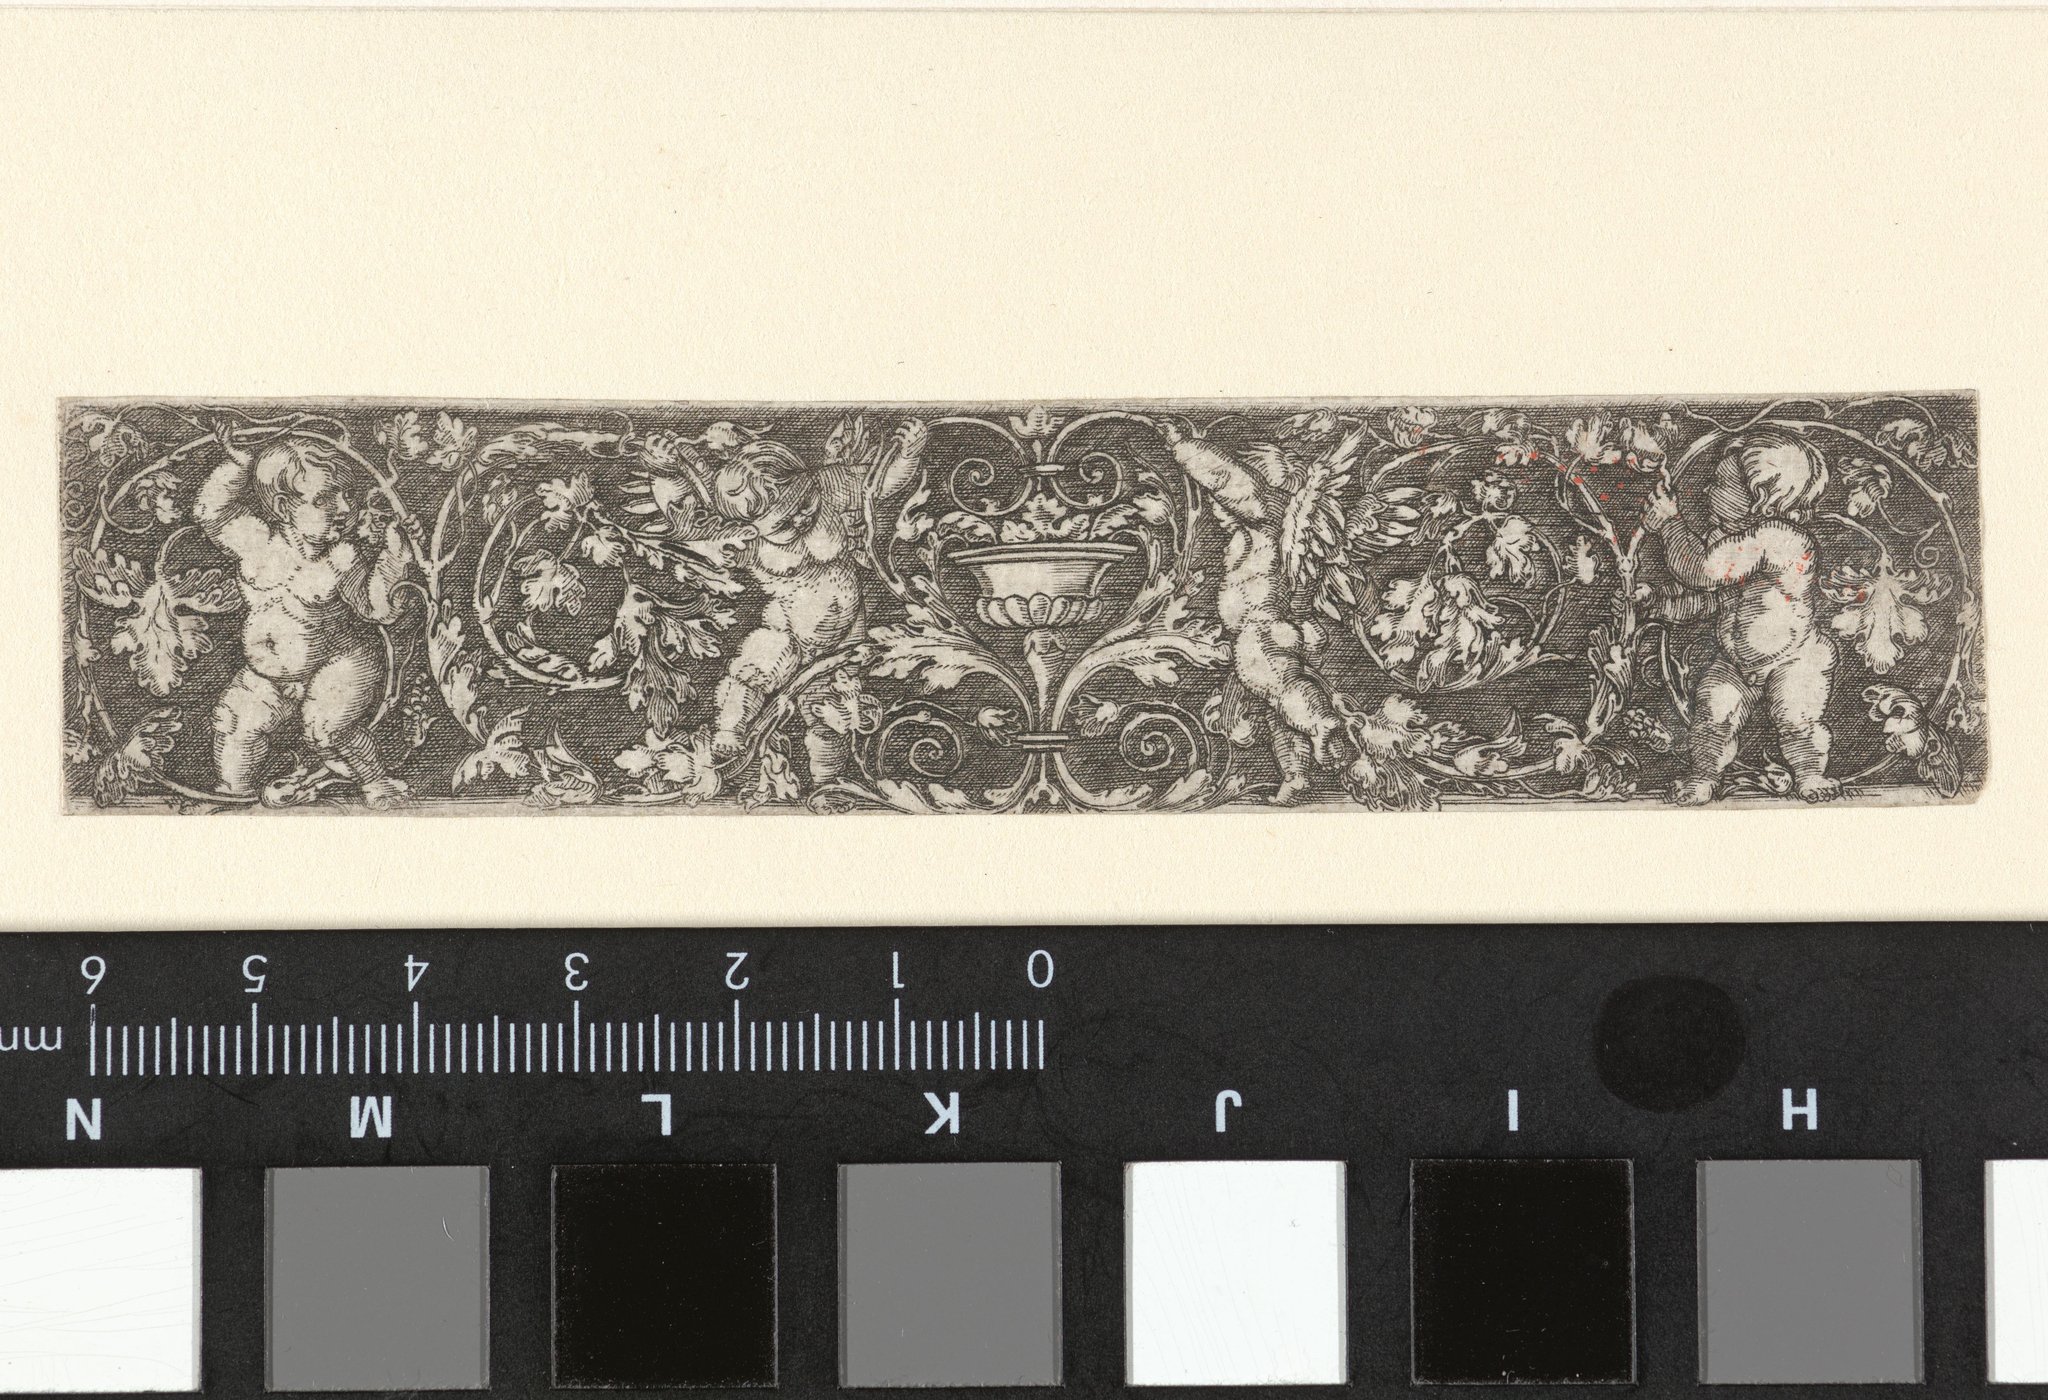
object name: ornament print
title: Fries met een vaas tussen twee putti en bladranken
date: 1510-1550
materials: paper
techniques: engraving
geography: germany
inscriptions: collector's mark: Lugt 240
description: Aan beide uiteinden van het fries staat nog een putto.